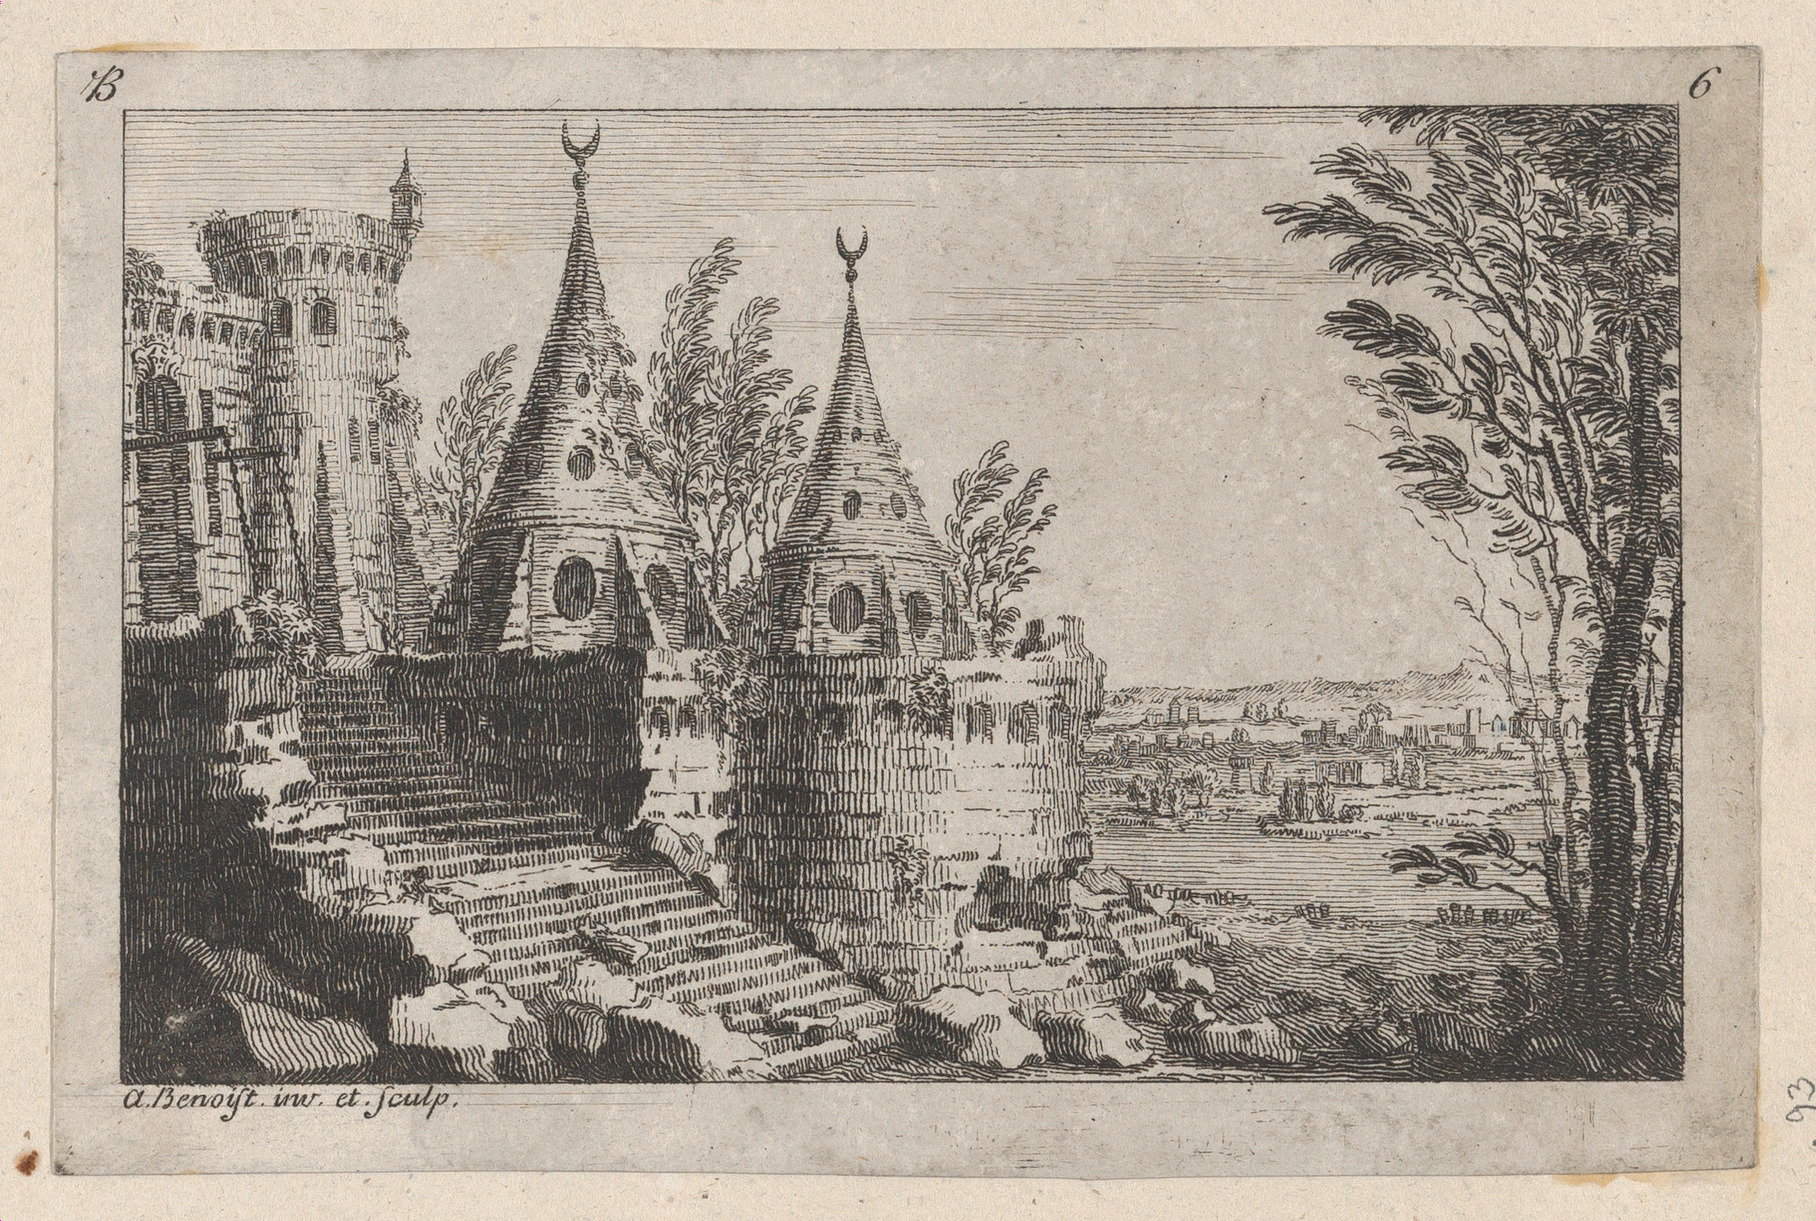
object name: print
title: View of a Castle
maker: antoine benoist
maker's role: artist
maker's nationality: french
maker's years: 1721-1770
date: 1736-1770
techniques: engraving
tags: castles,trees